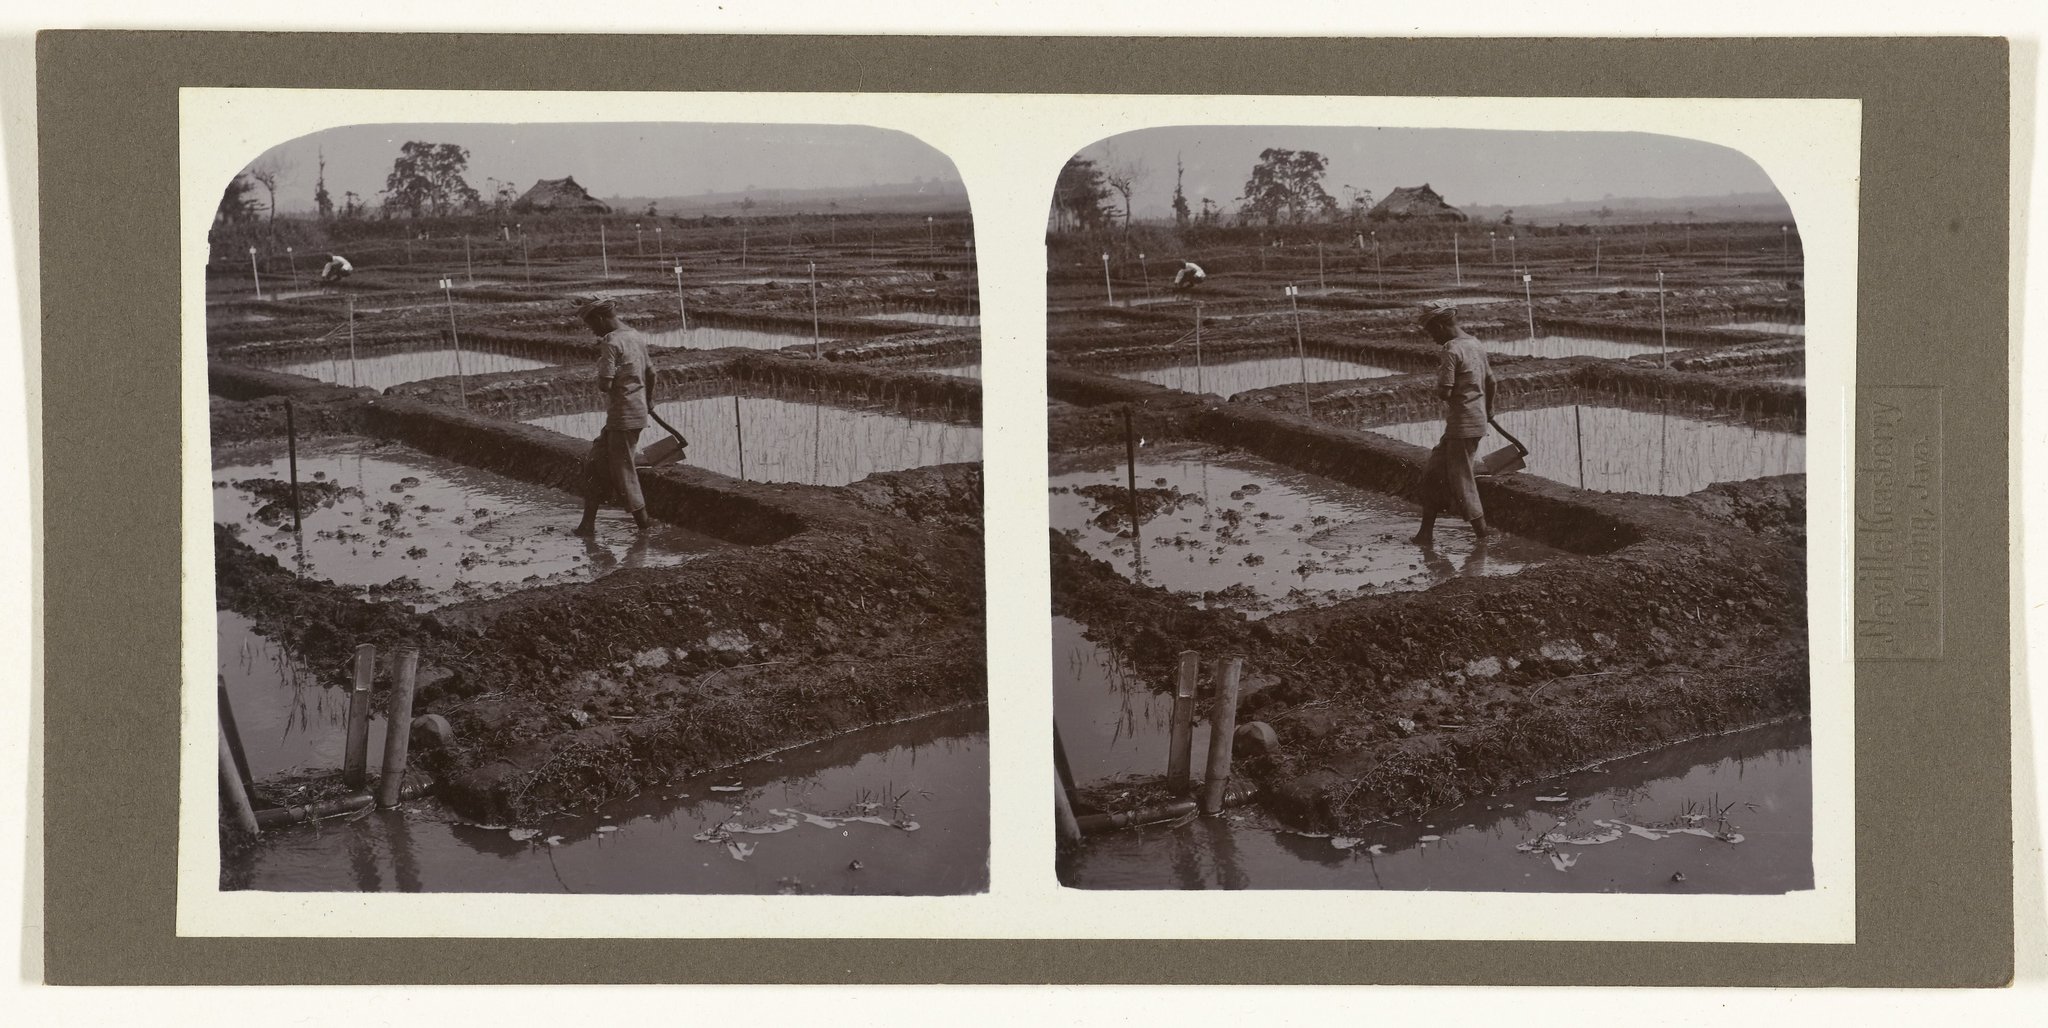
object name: stereograph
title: S 1 No 10. Rijstcultuur. Sawahbewerking.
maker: neville keasberry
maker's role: fotograaf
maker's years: 1866-1944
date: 1900-1935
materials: cardboard, paper, photographic support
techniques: albumen print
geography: malang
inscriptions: signature: ‘Neville Keasberry, Malang (Java)’